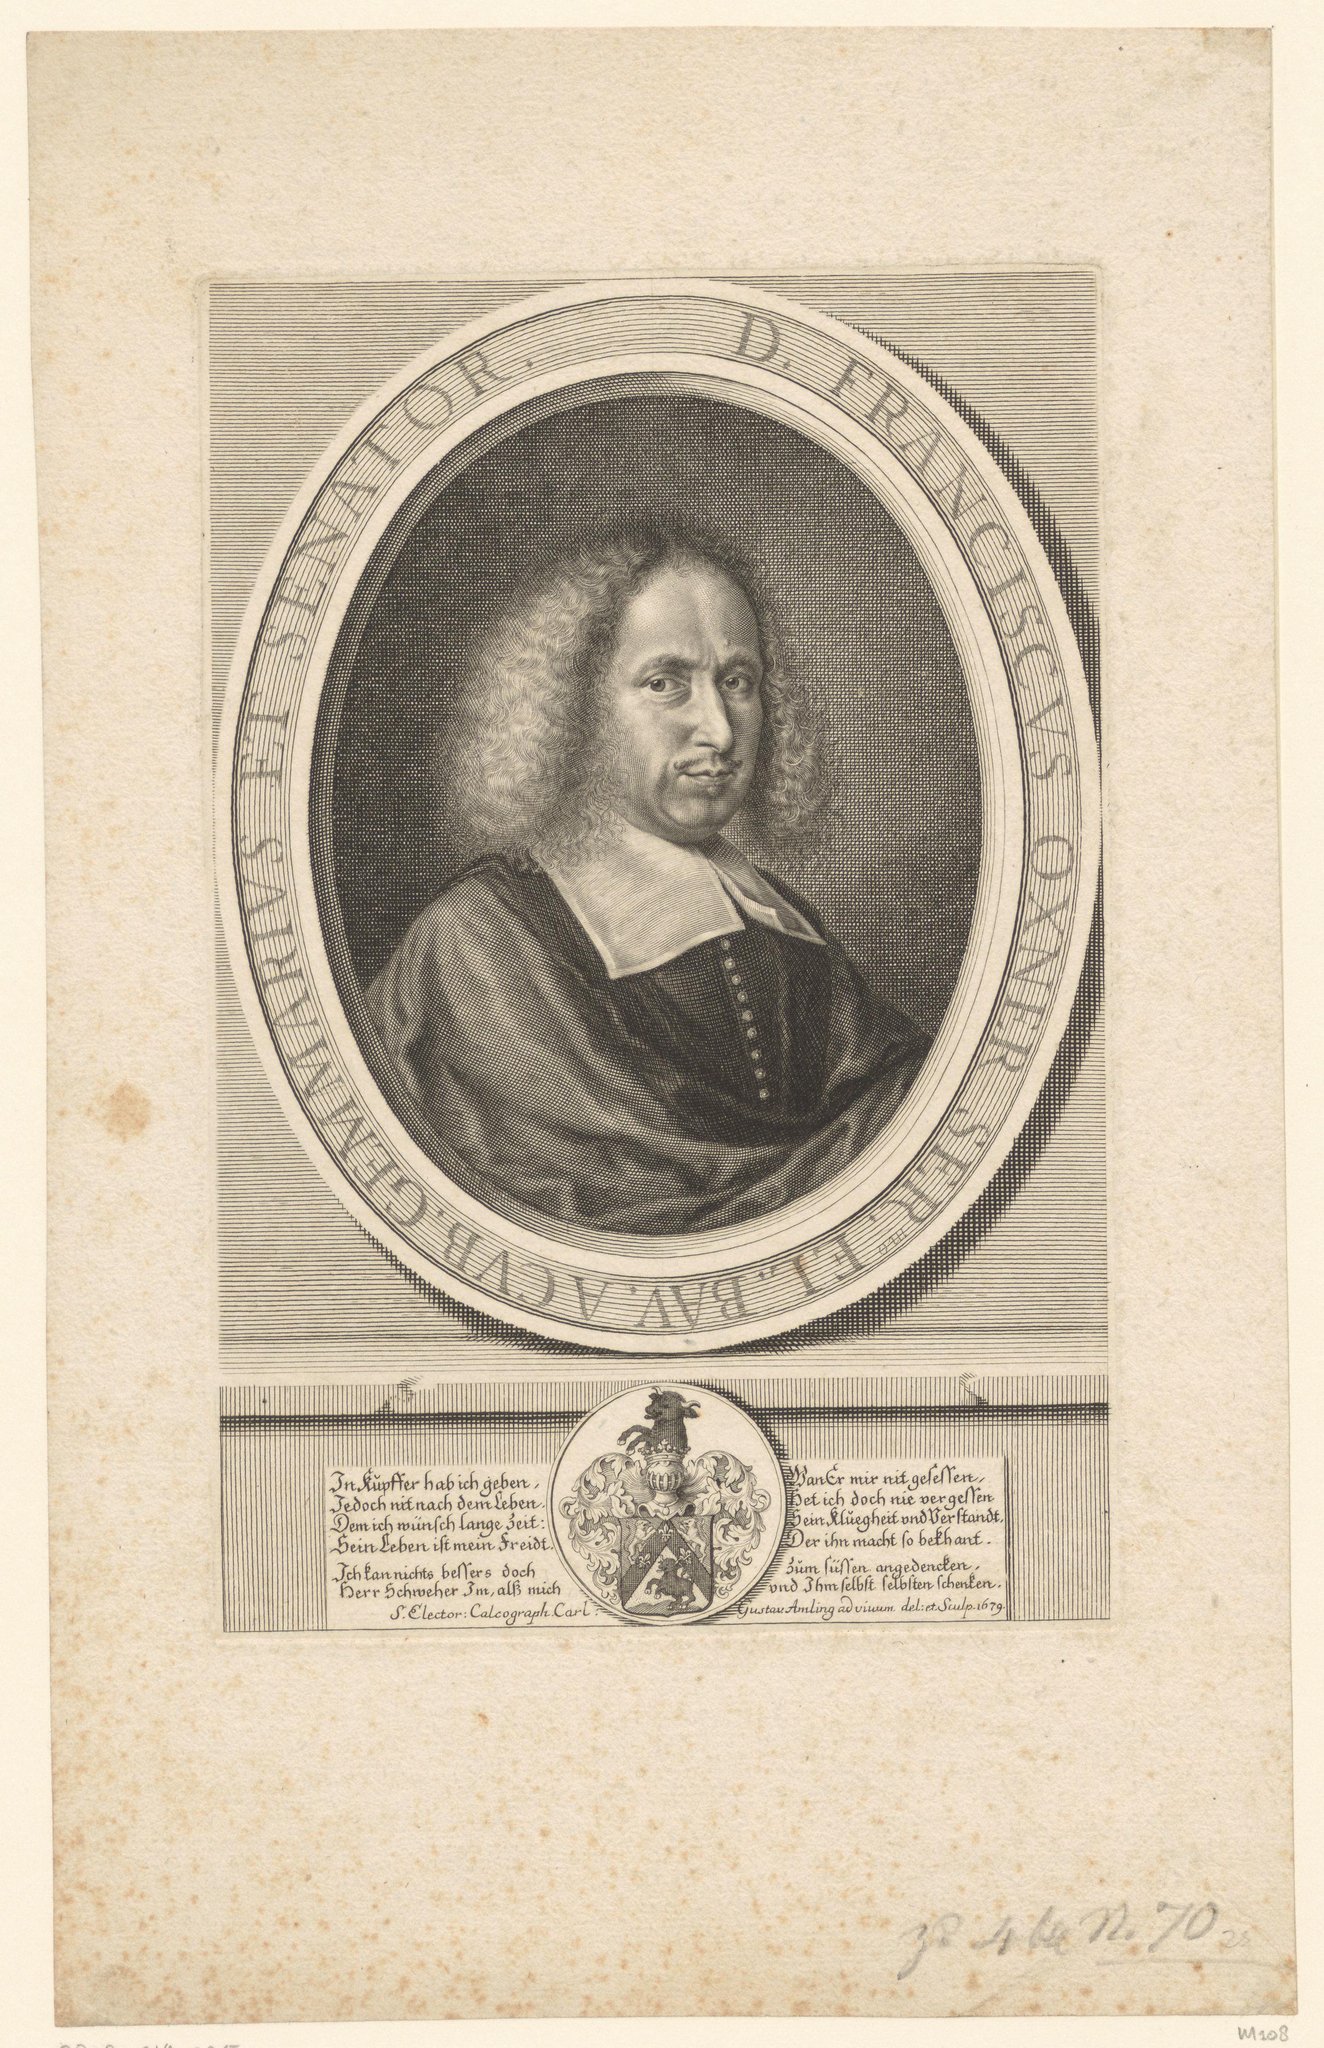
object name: print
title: Portret van Franz Oxner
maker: karl gustav amling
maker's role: print maker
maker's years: 1651-1702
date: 1679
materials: paper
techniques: engraving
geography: munich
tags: goldsmith, historical persons, armorial bearing, heraldry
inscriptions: collector's mark: Lugt 2228